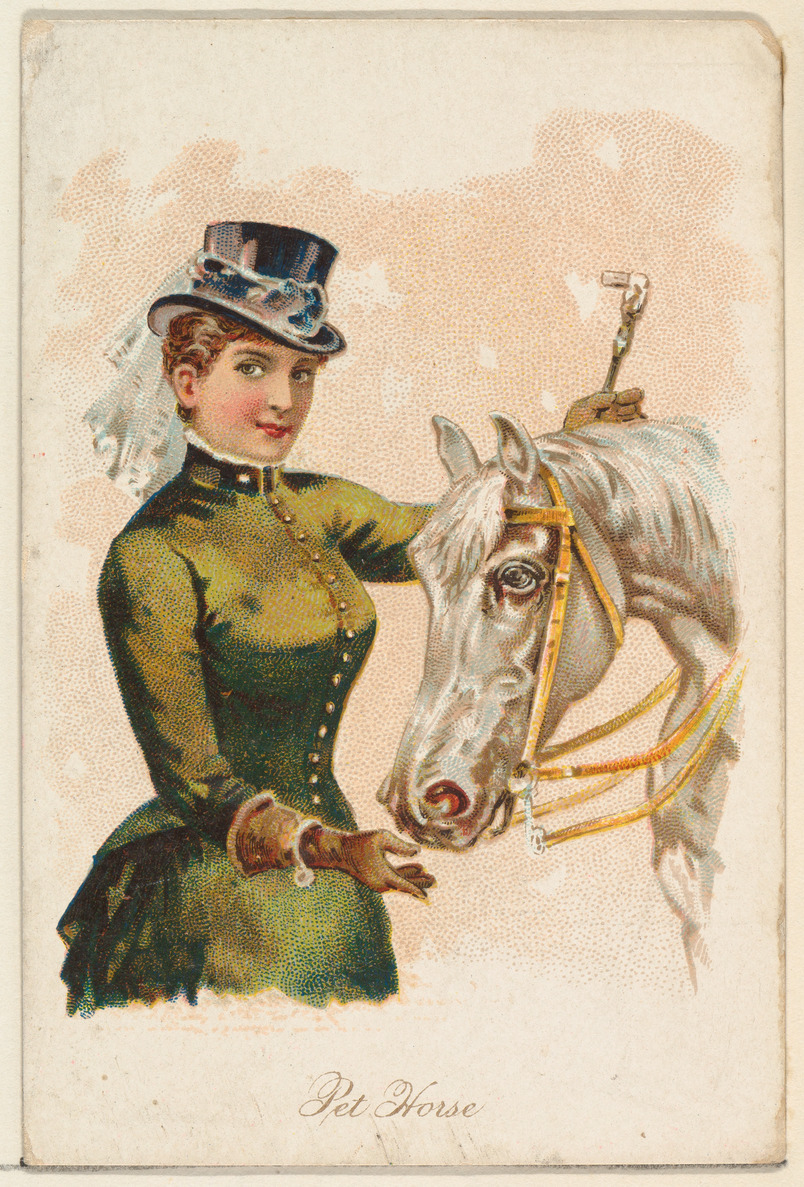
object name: print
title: Pet Horse, from the Household Pets series (N194) issued by Wm. S. Kimball & Co.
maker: william s. kimball & company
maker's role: publisher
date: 1891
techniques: color lithograph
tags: women,horses